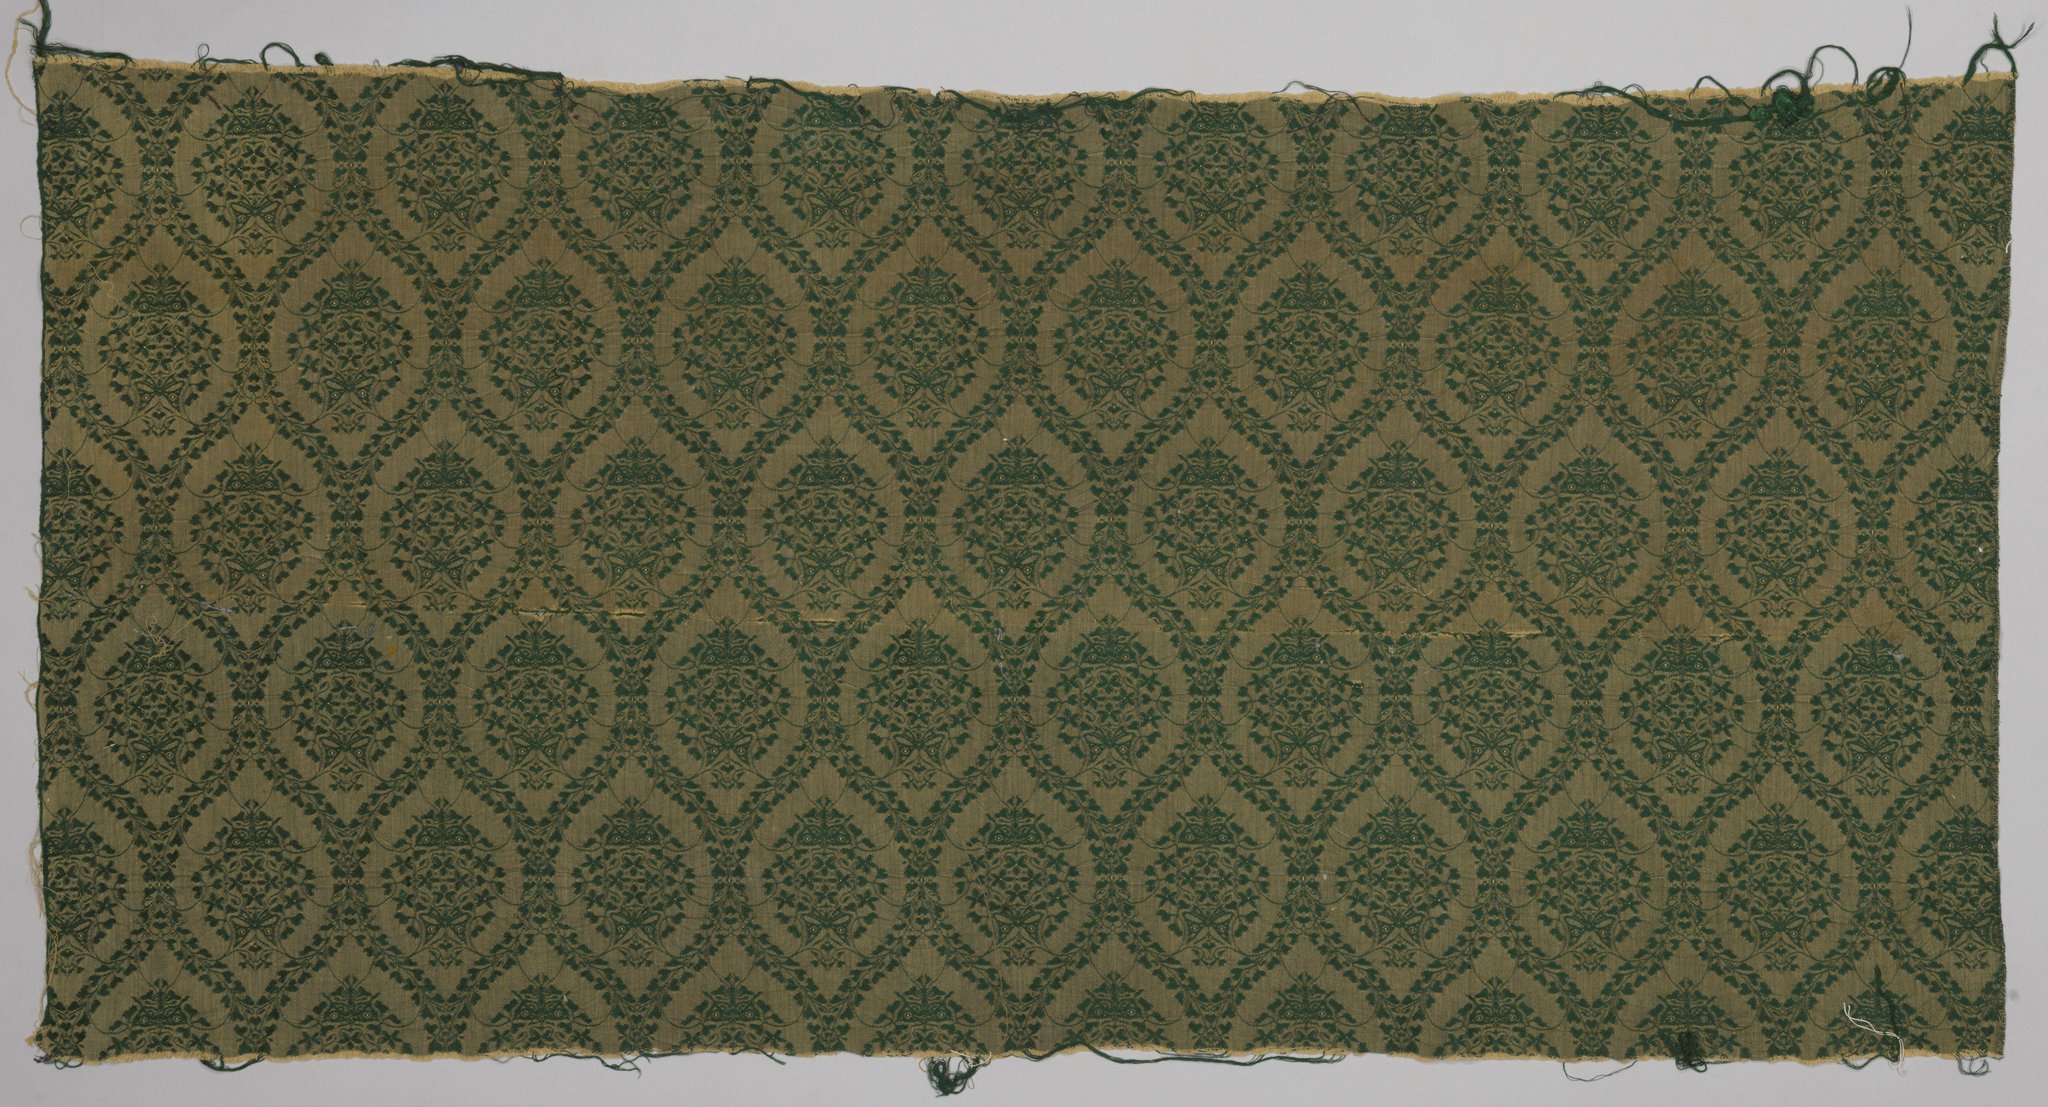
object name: upholstery fabric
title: Bespanningsstof, jacquardweefsel met patroon van spitsovale velden met bladranken, donkergroene inslag op zachtgele ketting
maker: theo nieuwenhuis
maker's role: designer, draughtsman, print maker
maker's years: 1866-1951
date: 1920-1930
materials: cotton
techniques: jacquard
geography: netherlands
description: Bespanningsstof, jacquardweefsel met patroon van spitsovale velden met bladranken, donkergroene inslag op zachtgele ketting.